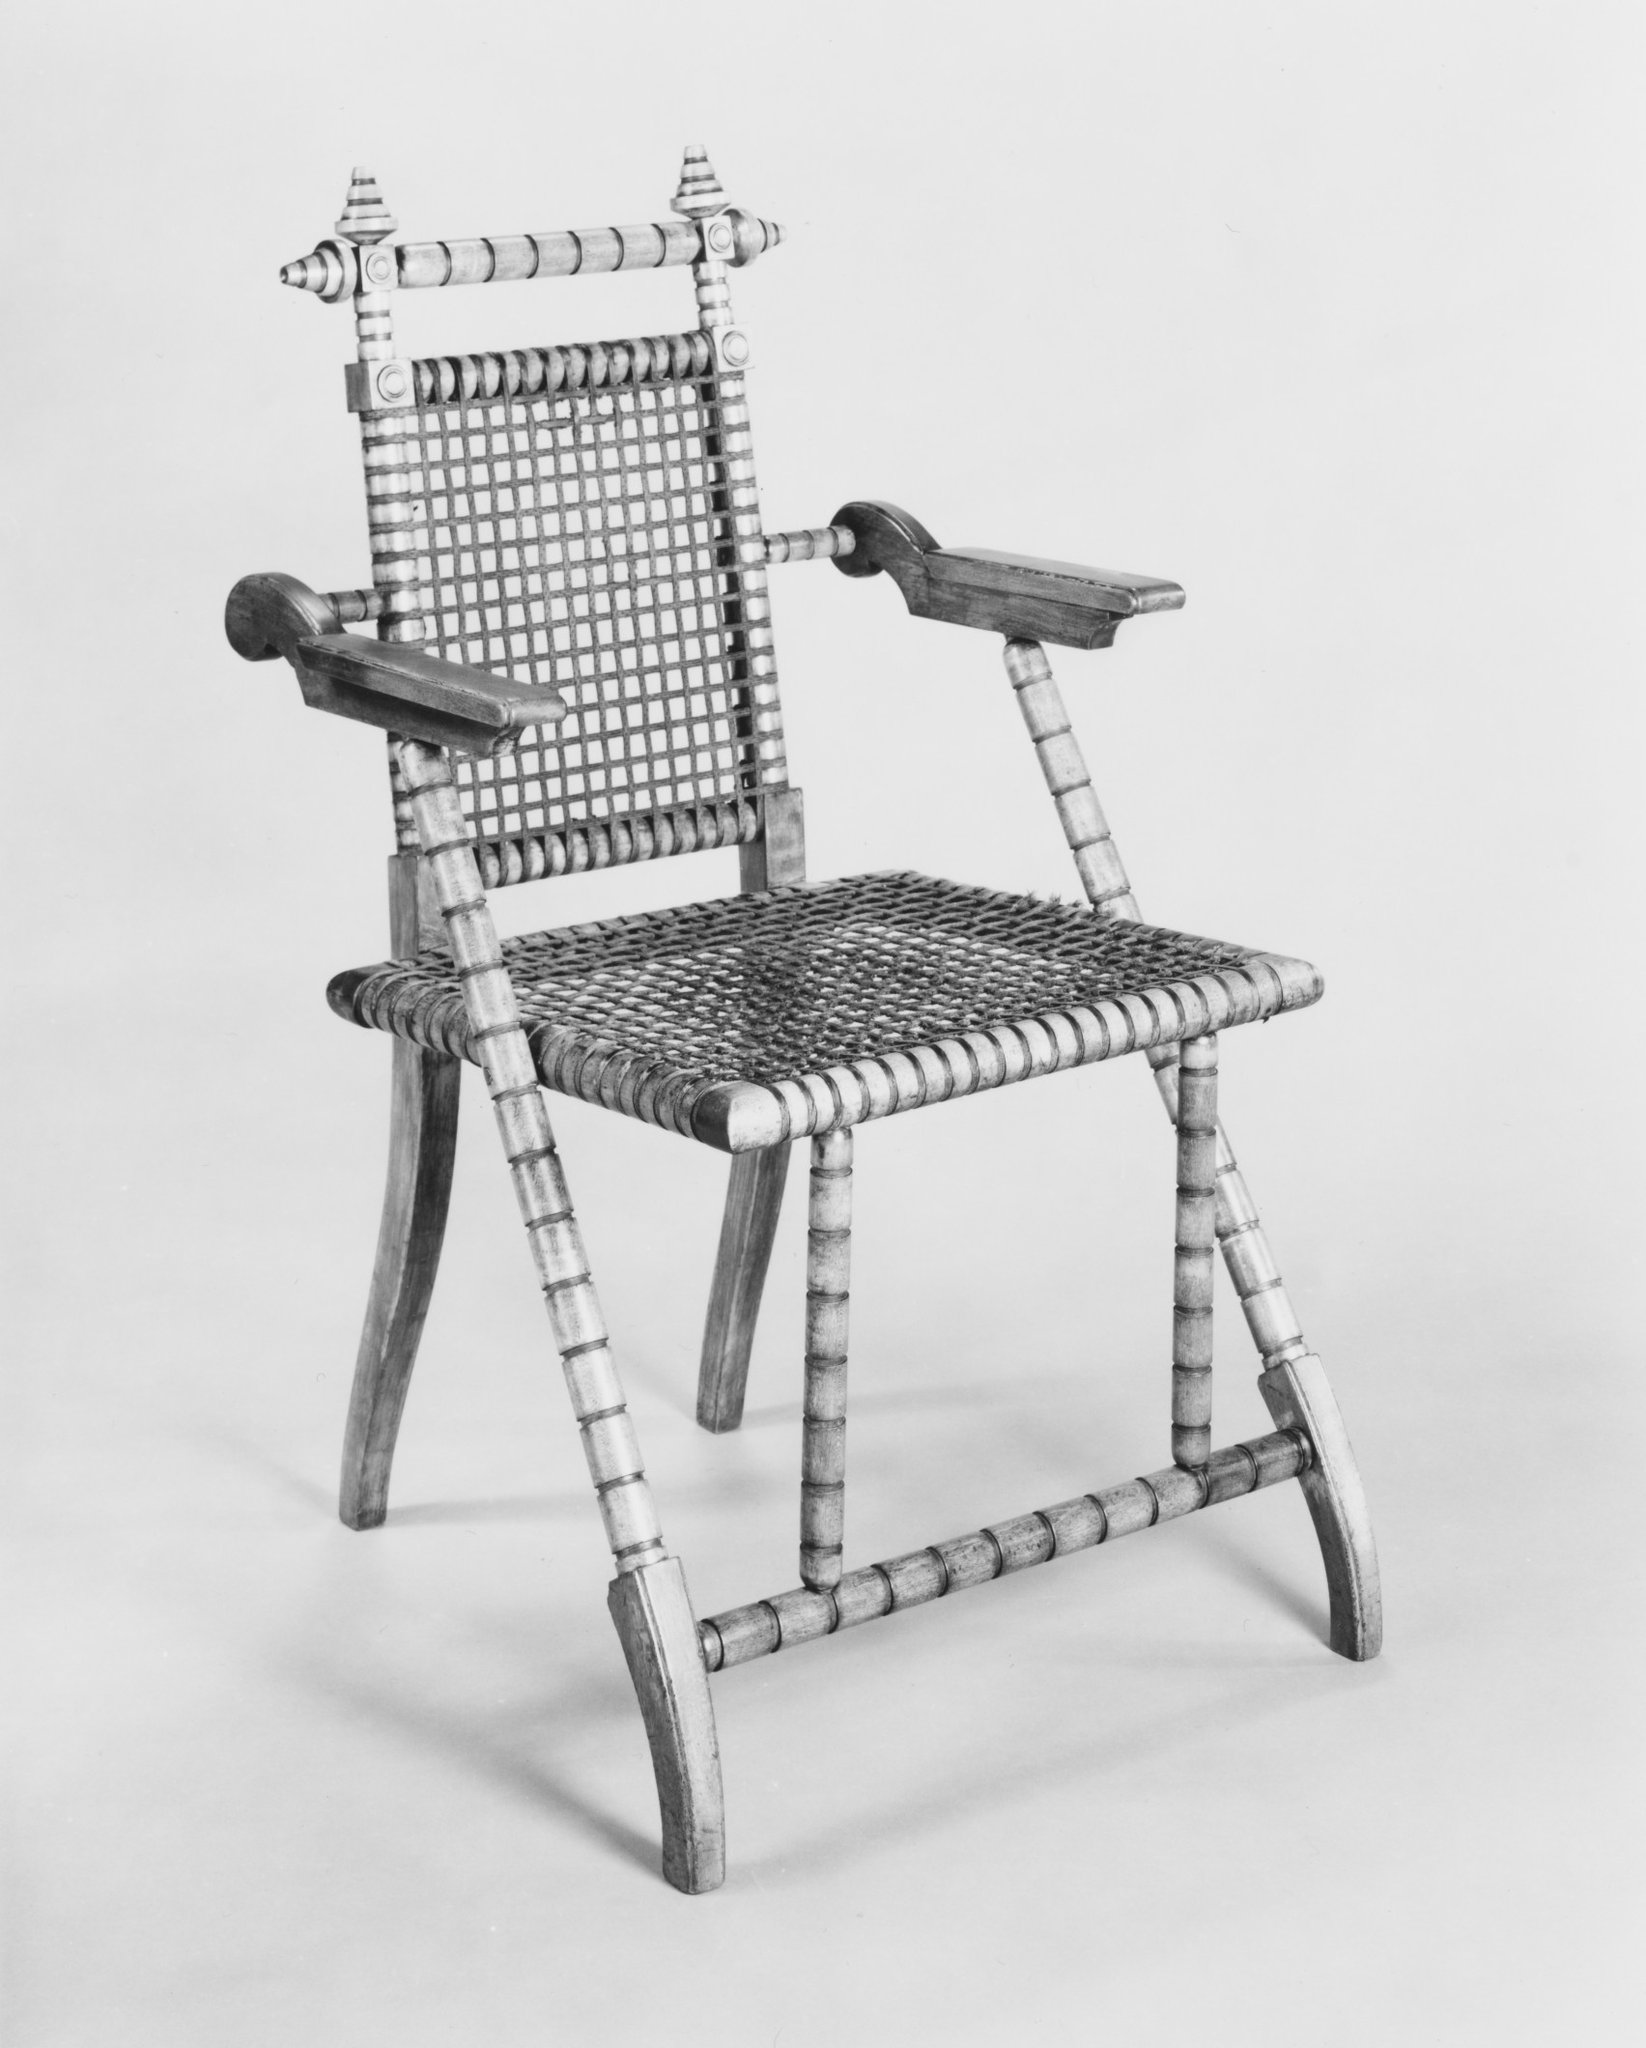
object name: folding armchair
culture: american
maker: george jakob hunzinger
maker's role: maker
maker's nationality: american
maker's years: 1835-1898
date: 1876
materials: wood, steel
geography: united states